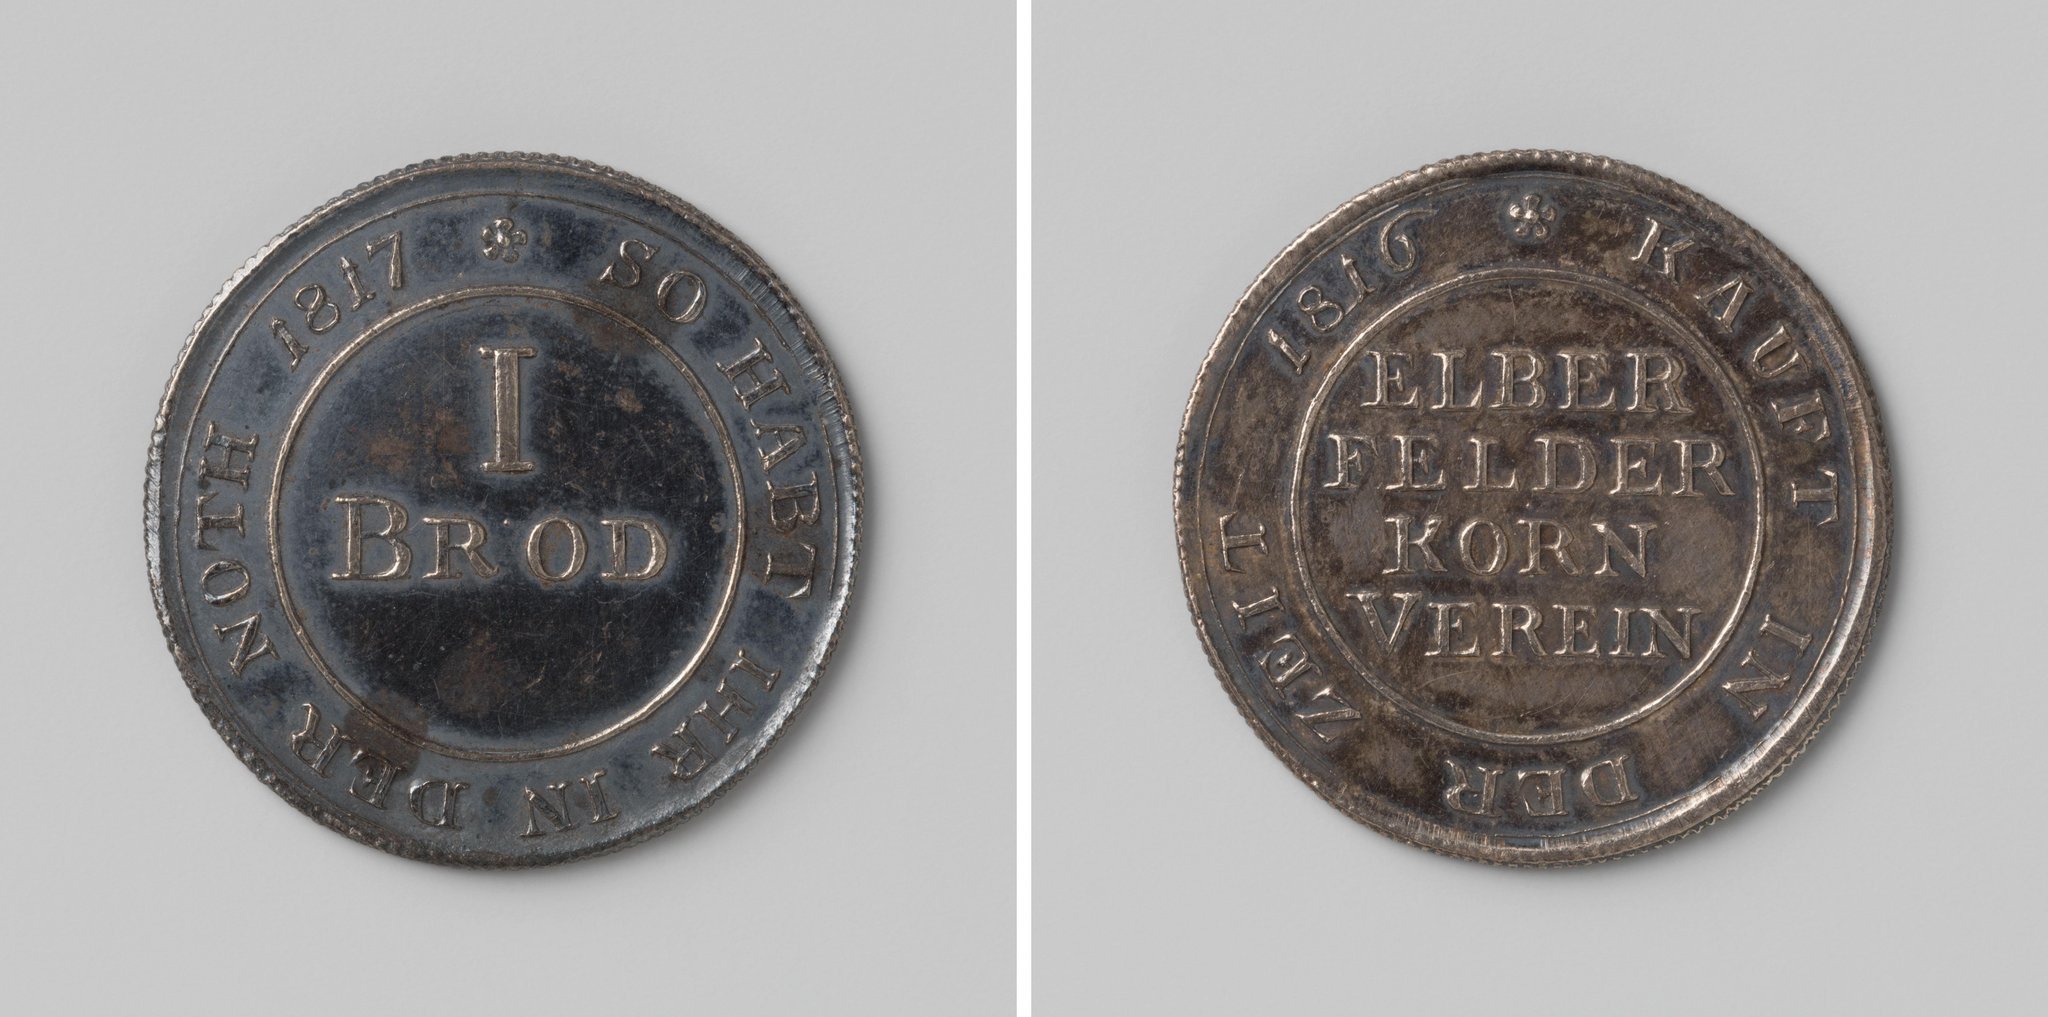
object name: armenloodje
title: Elberfelder Kornverein, loodje goed voor een brood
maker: Anonymous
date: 1817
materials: silver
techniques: striking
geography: elberfeld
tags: elberfeld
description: Zilveren penning. Voorzijde: opschrift binnen omschrift. Keerzijde: opschrift binnen omschrift